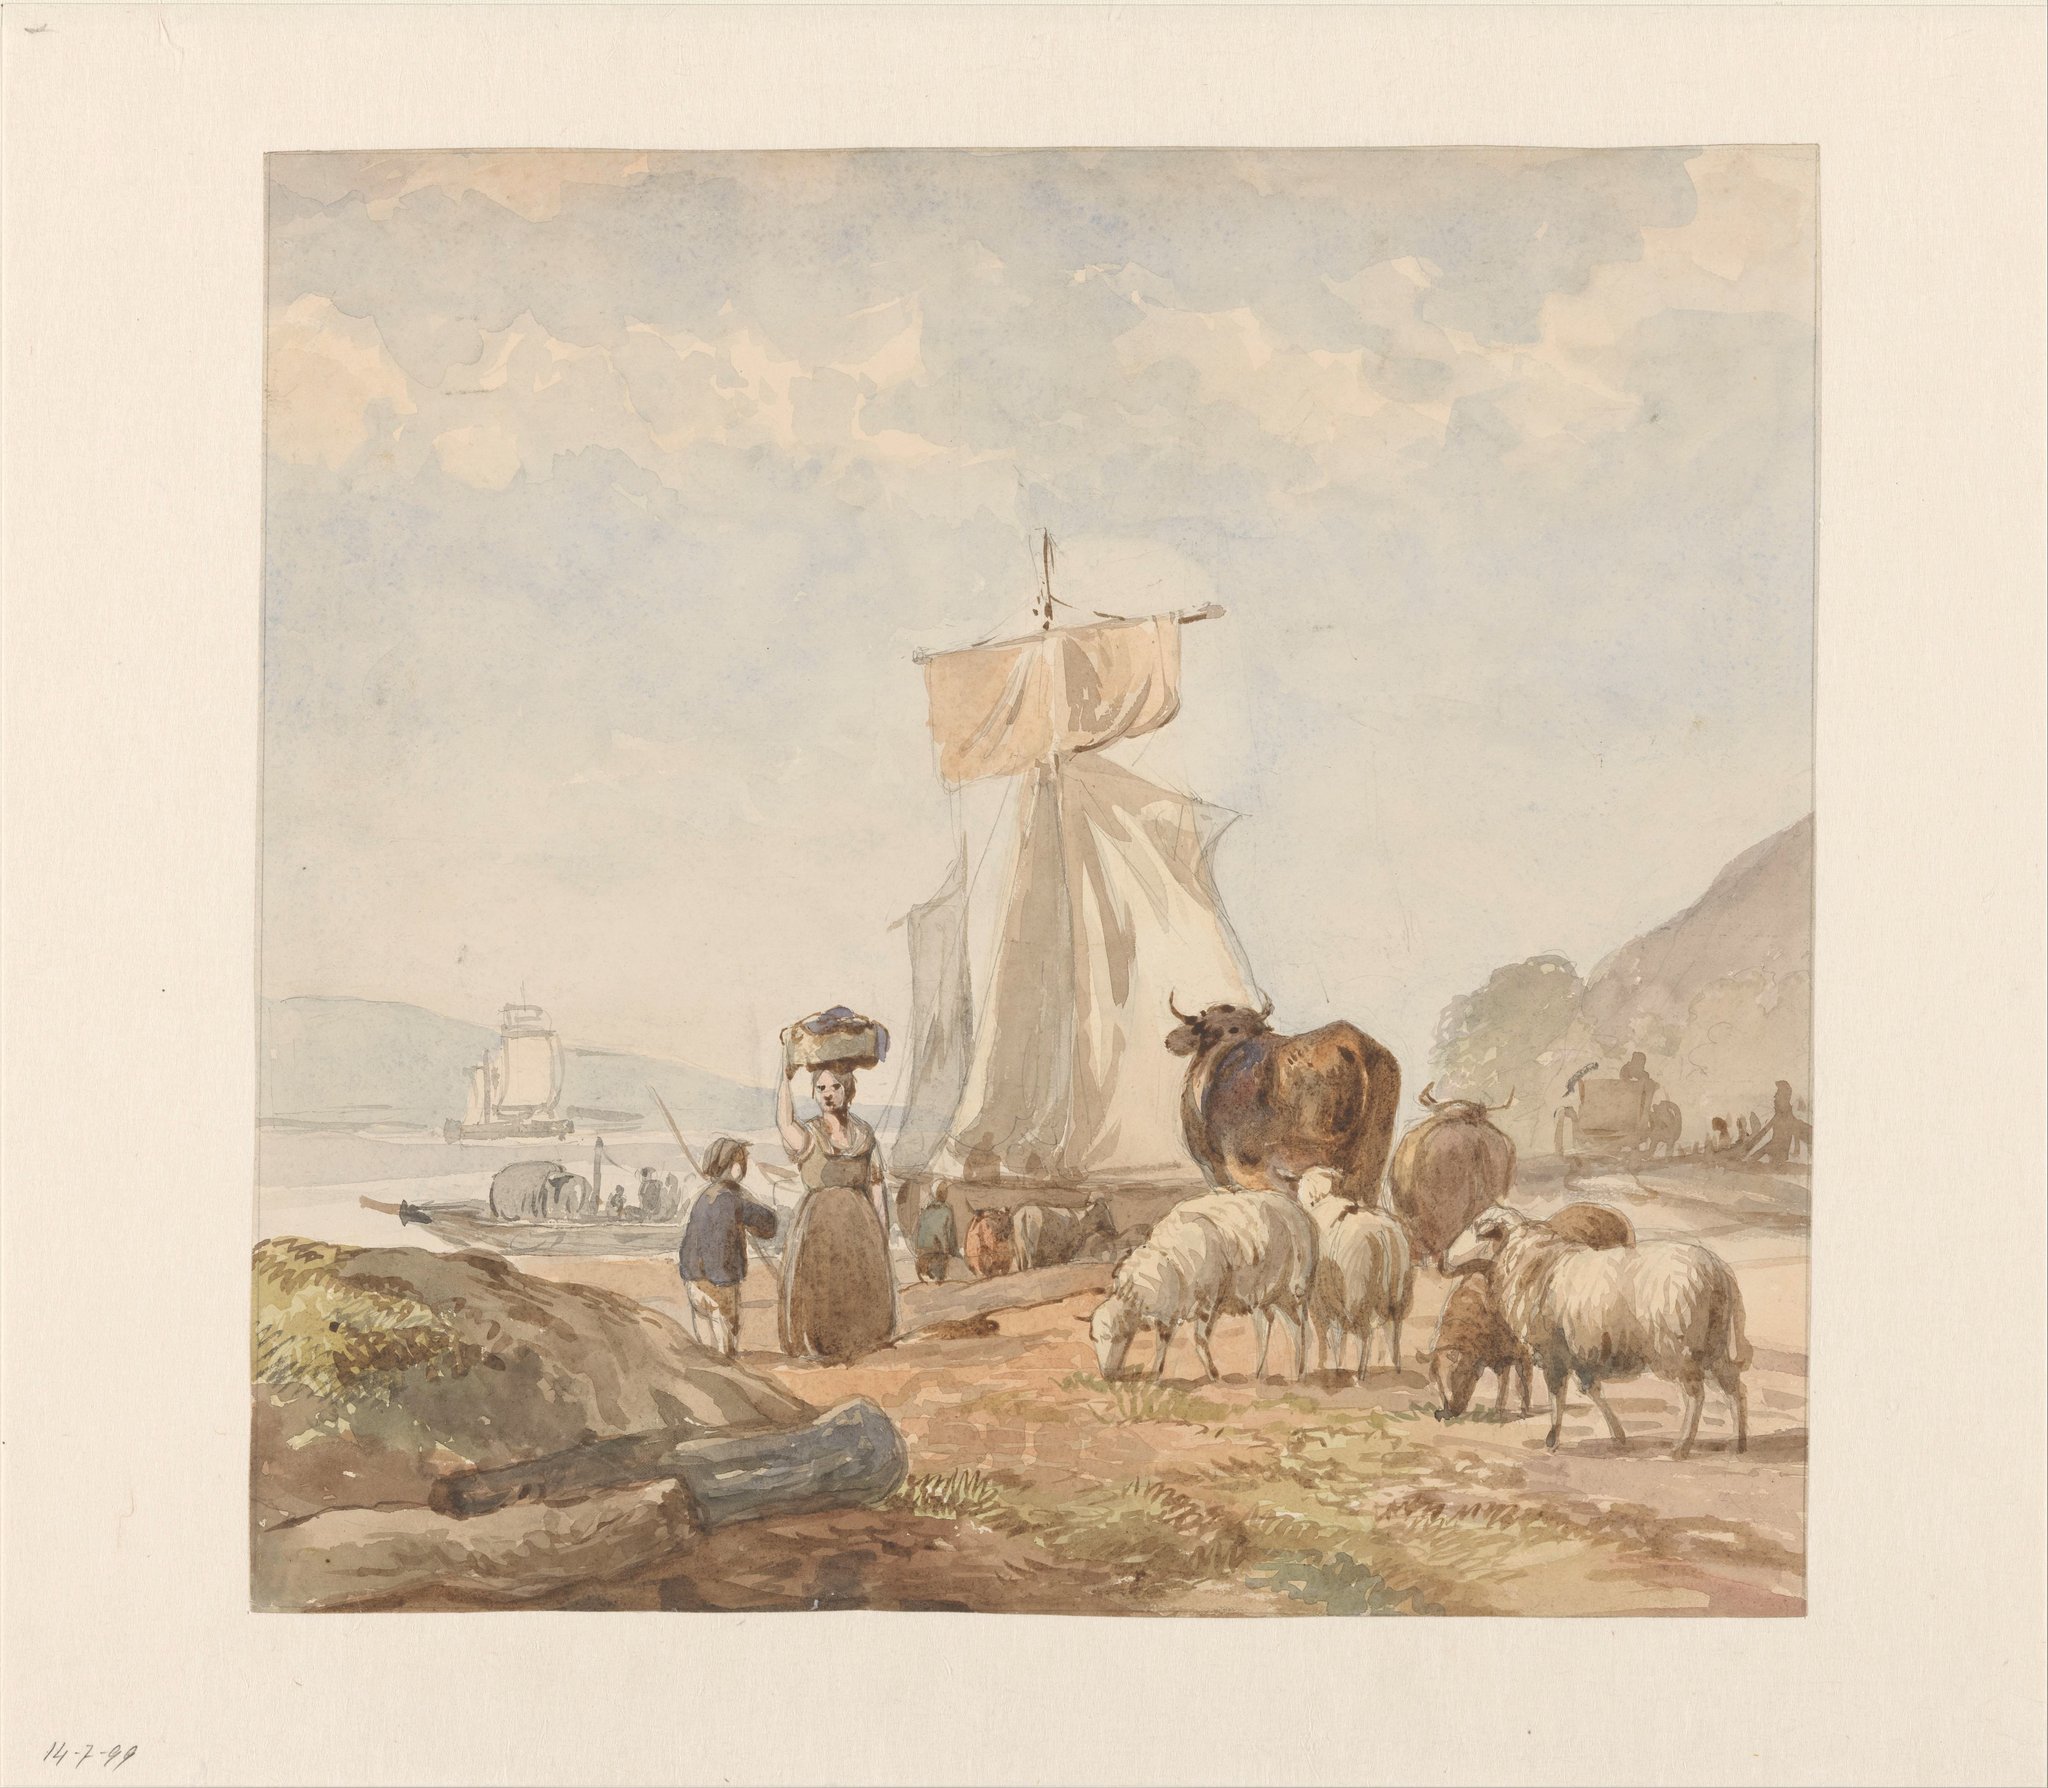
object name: drawing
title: Figuren met vee bij rivieroever met veerboot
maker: julius jacobus van de sande bakhuyzen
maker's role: draughtsman, painter, print maker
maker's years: 1835-1925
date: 1845-1925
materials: paper, pencil, watercolor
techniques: brush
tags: sailing-ship, sailing-boat, cattle, ferry